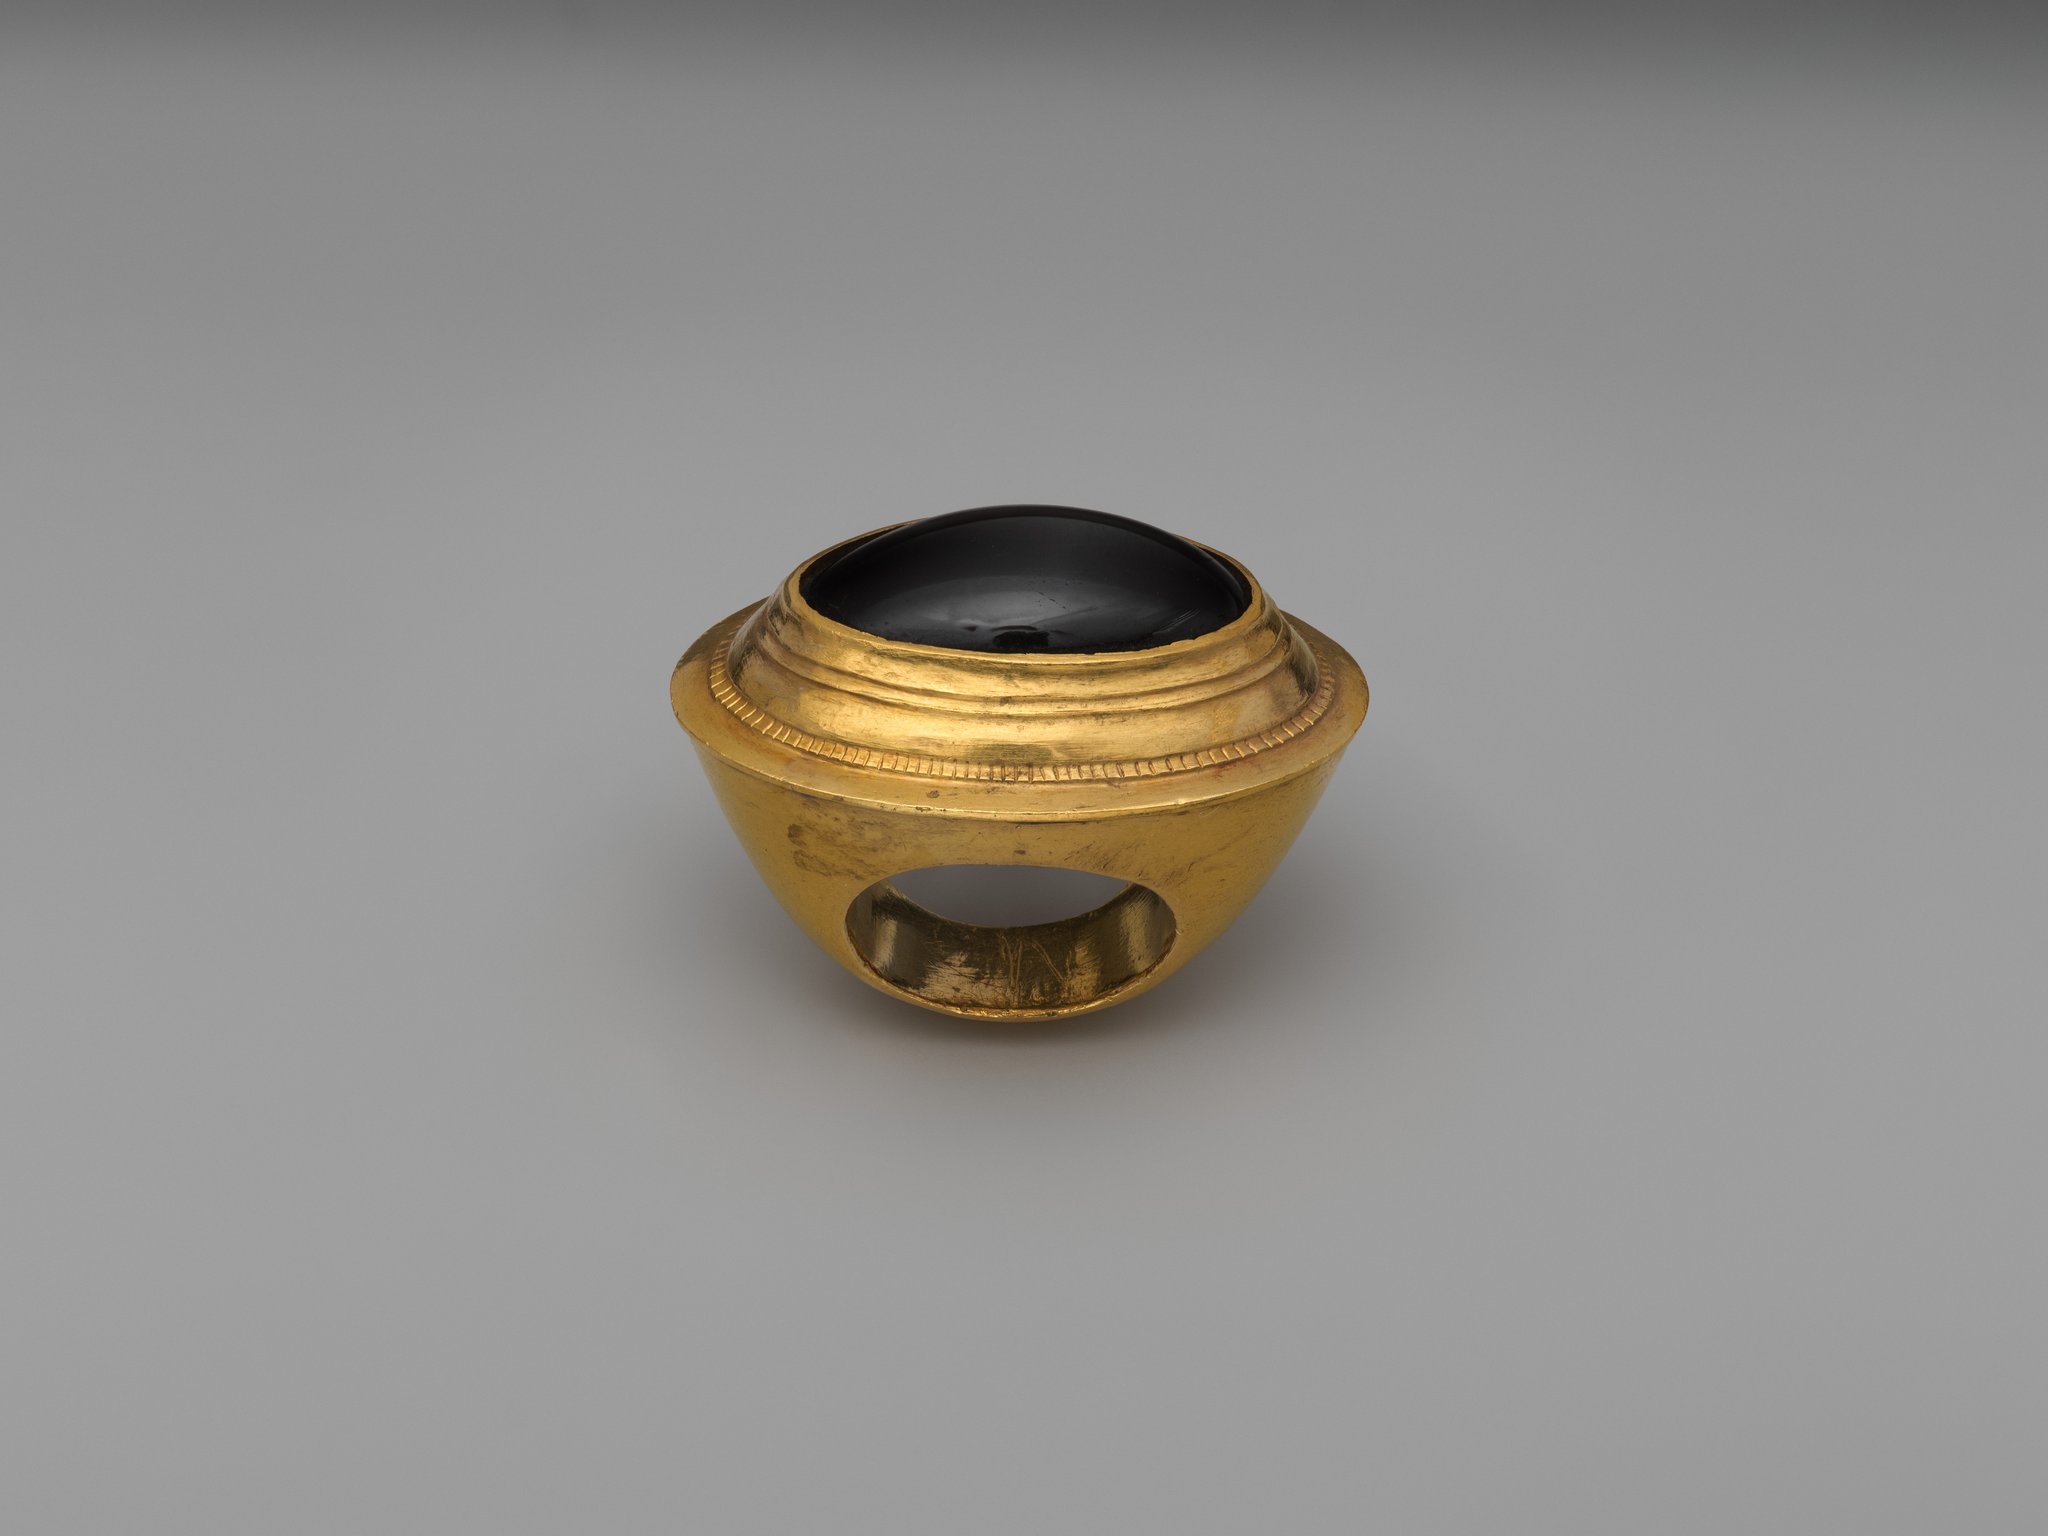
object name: ring with garnet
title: Gold ring with garnet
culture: greek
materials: gemstone, gold